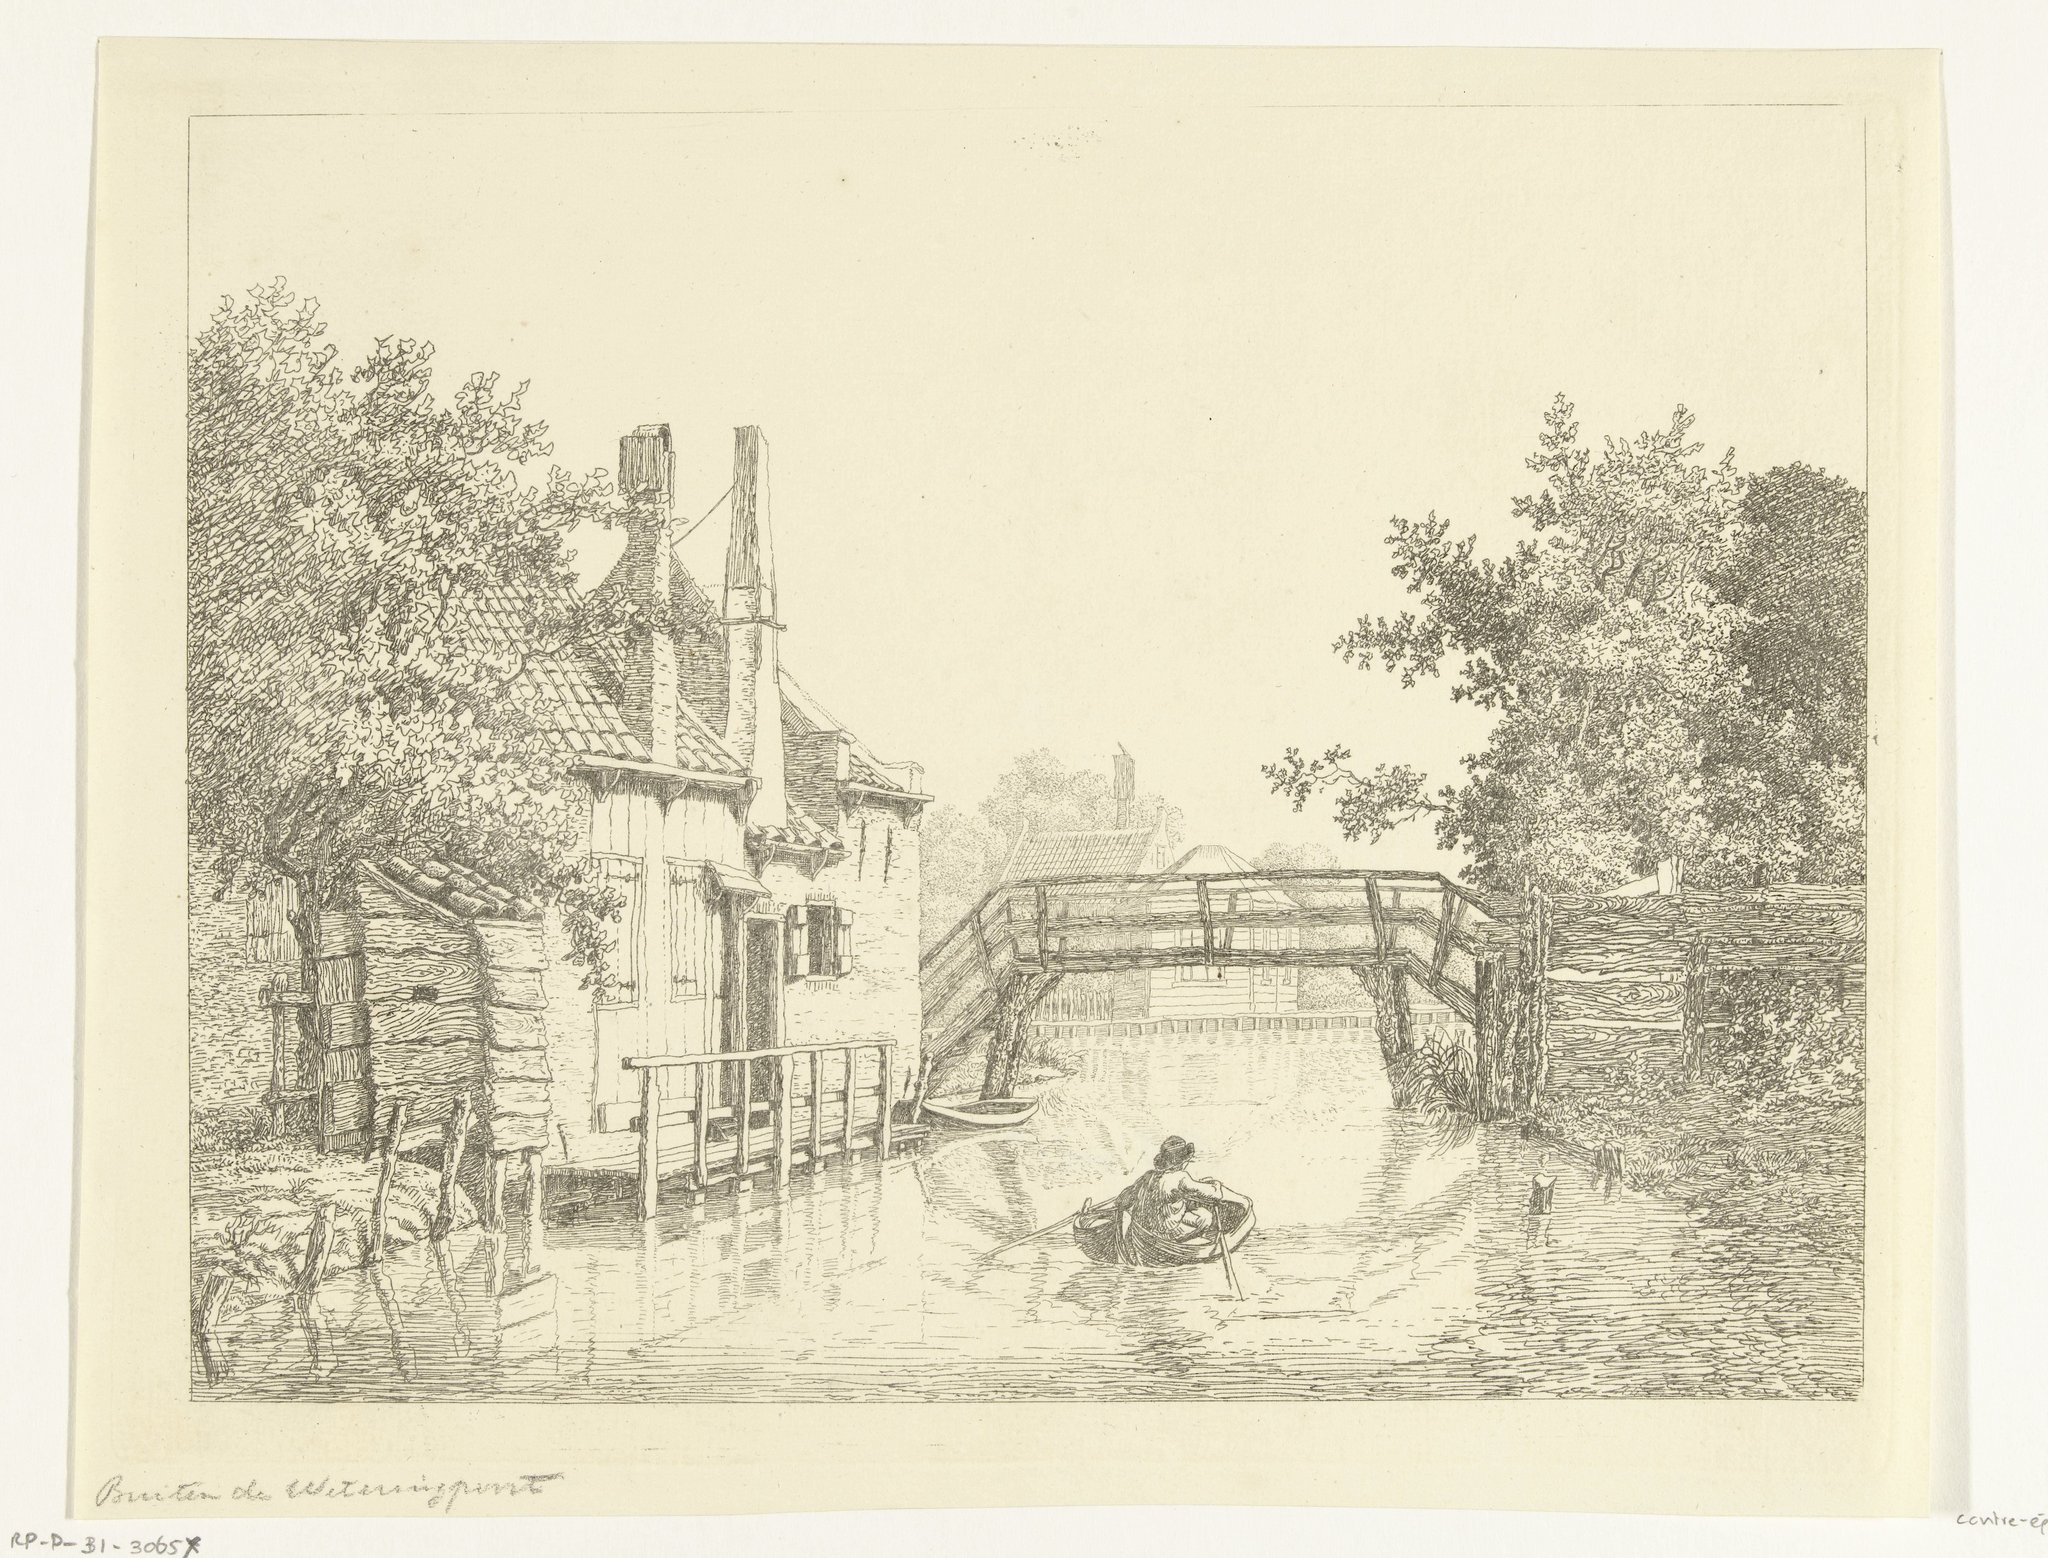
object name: print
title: Buiten de Weteringpoort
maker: anthonie van den bos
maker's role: draughtsman, print maker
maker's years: 1763-1838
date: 1778-1838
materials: paper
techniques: printmaking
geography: netherlands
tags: rowing-boat, canoe, etc. (+ one person ~ traffic and transport)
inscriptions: collector's mark: Lugt 2228